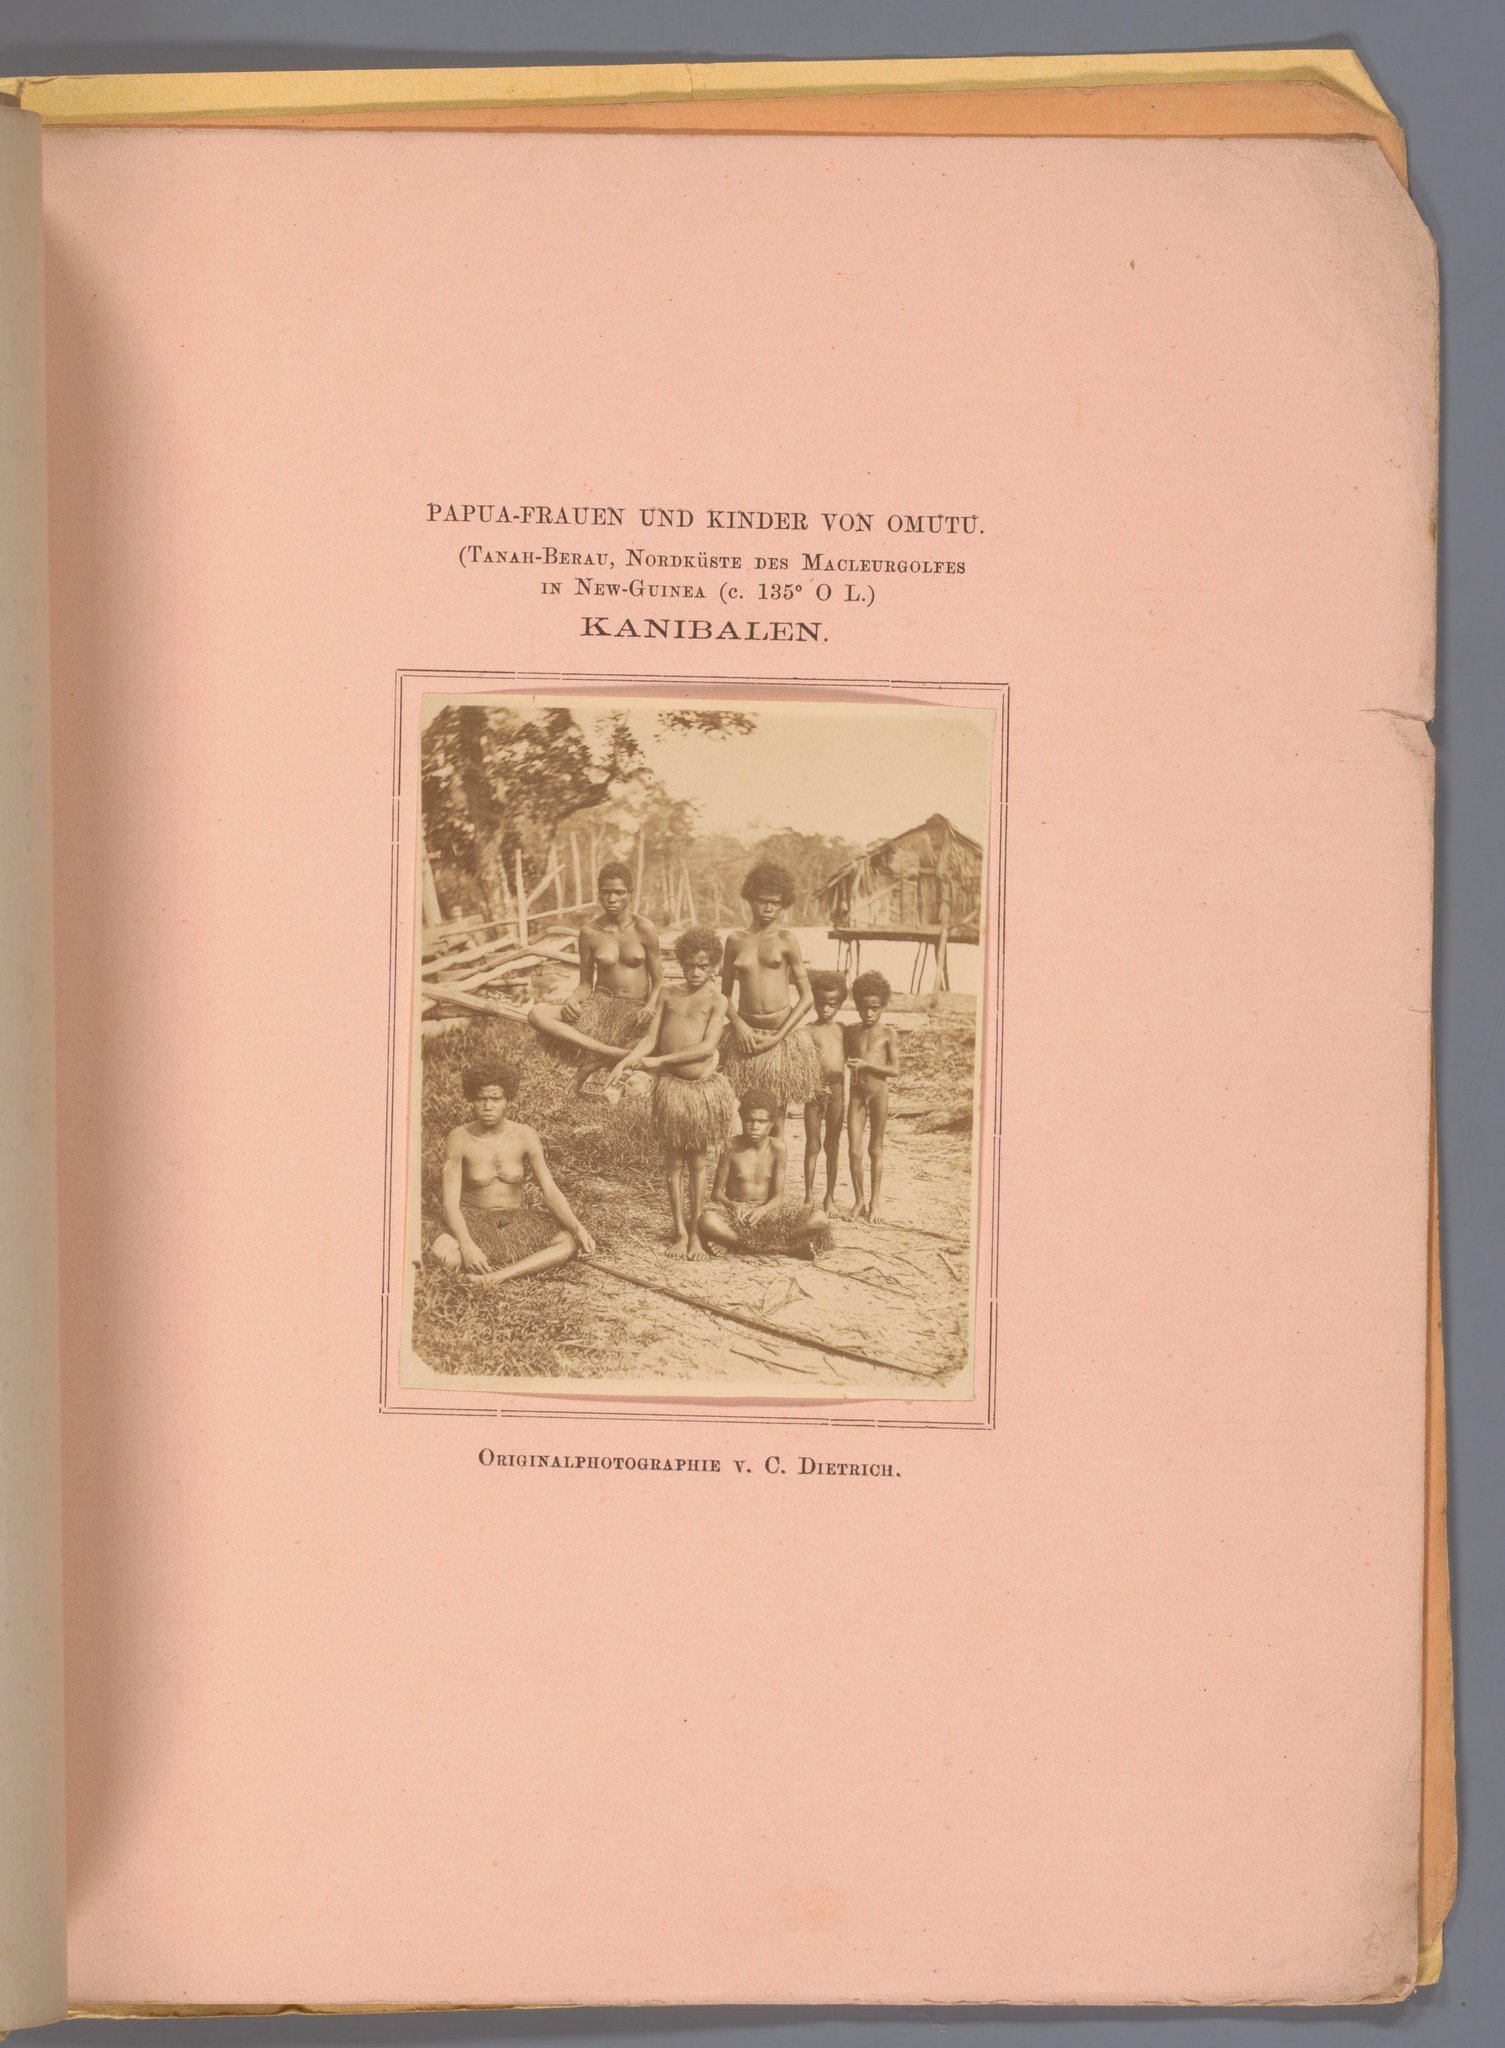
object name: photograph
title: Papua-Frauen und Kinder von Omutu (...) Kanibalen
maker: c. dietrich (fotograaf)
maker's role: fotograaf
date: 1878-1883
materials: paper, photographic support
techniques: albumen print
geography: nieuw-guinea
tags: australian and oceanian races, cannibalism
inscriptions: title: ‘Papua-Frauen und Kinder von Omutu./ (Tanah-Berau, Nordküste des Macleurgolfes/ in New-Guinea (c. 135° O L.)/ Kanibalen.’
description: Portret van Papuavrouwen en kinderen van Omutu, Tanah-Berau, aan de Noordkust van de Macleurgolf in Nieuw-Guinea.